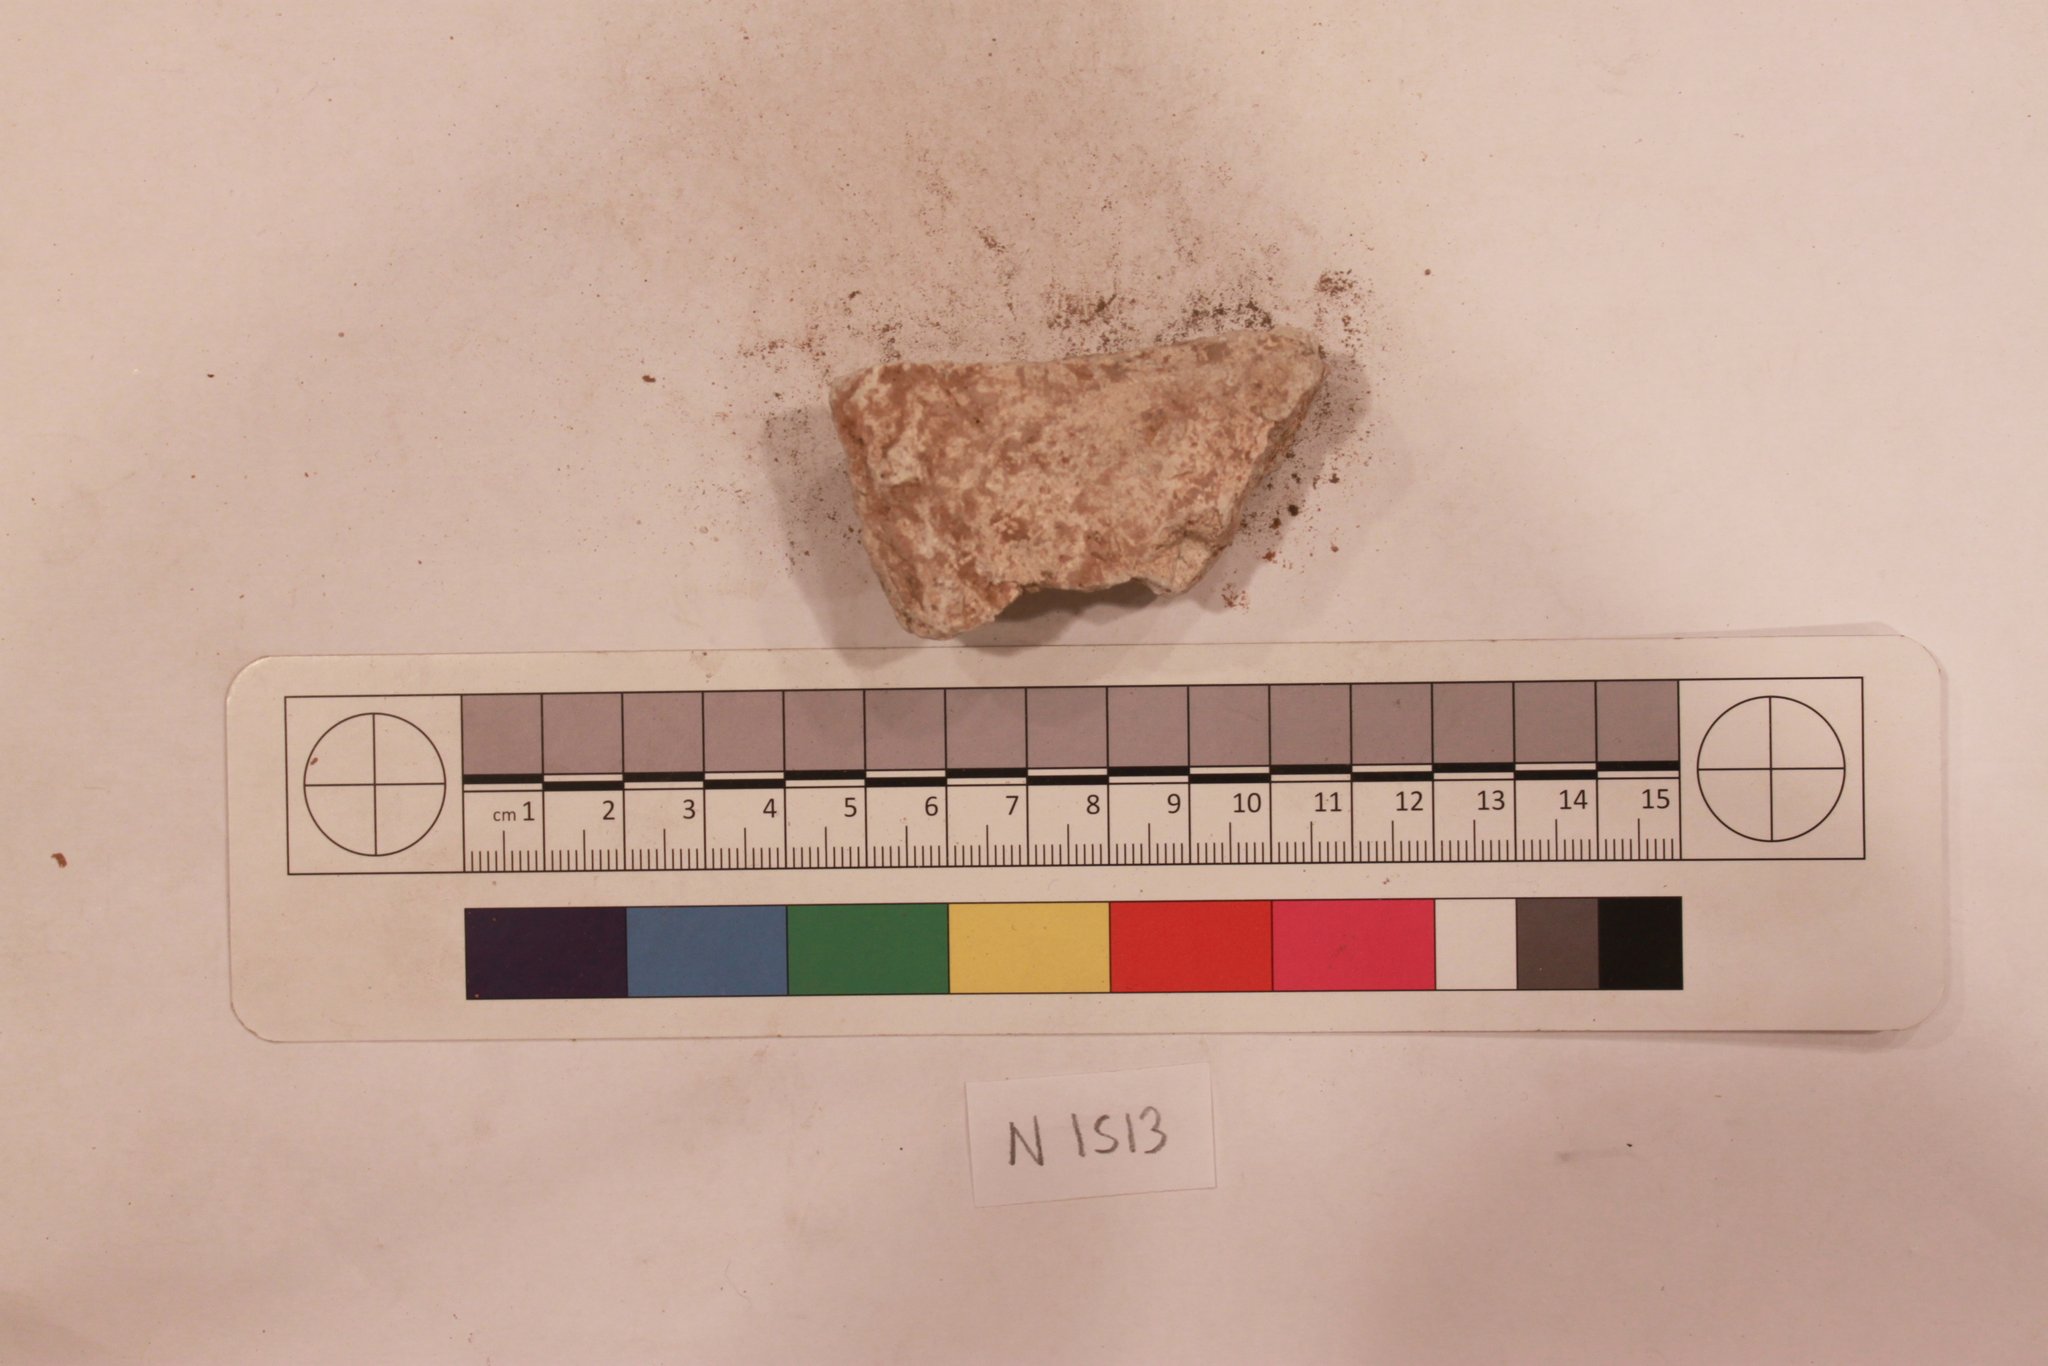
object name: fragment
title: Stucco Fragment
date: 701-1200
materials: plaster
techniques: carving, painting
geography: iran